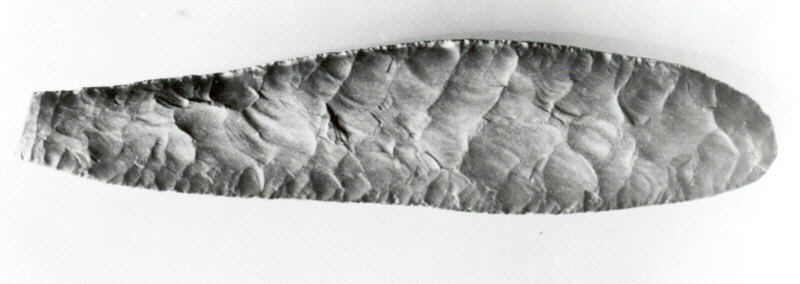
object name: knife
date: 7500-4500 BCE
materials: stone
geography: southern levant